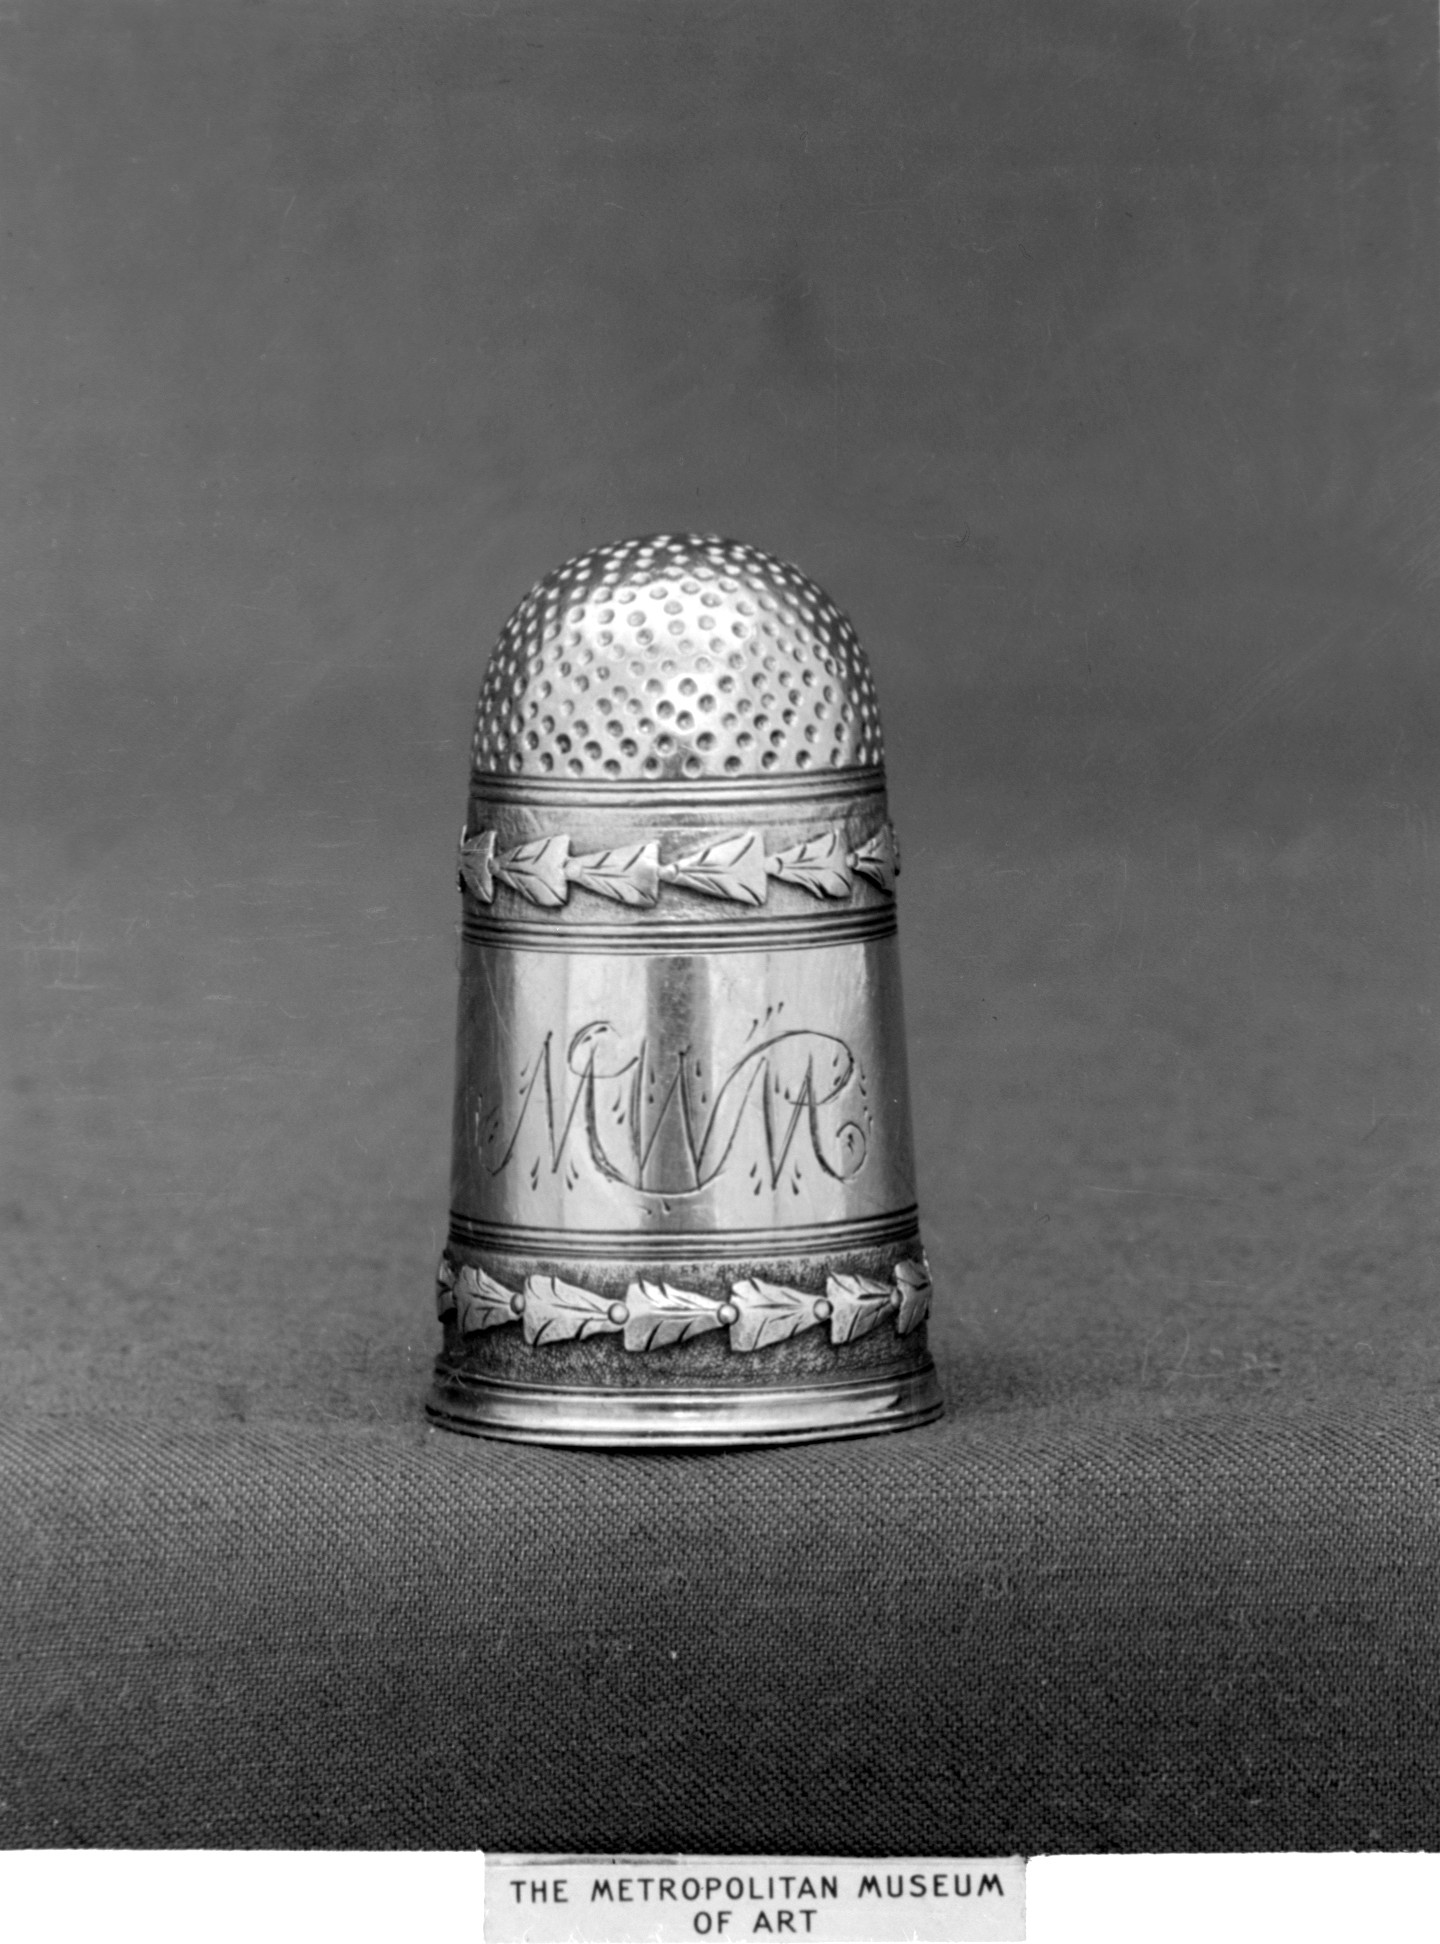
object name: thimble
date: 1801-1900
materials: gold